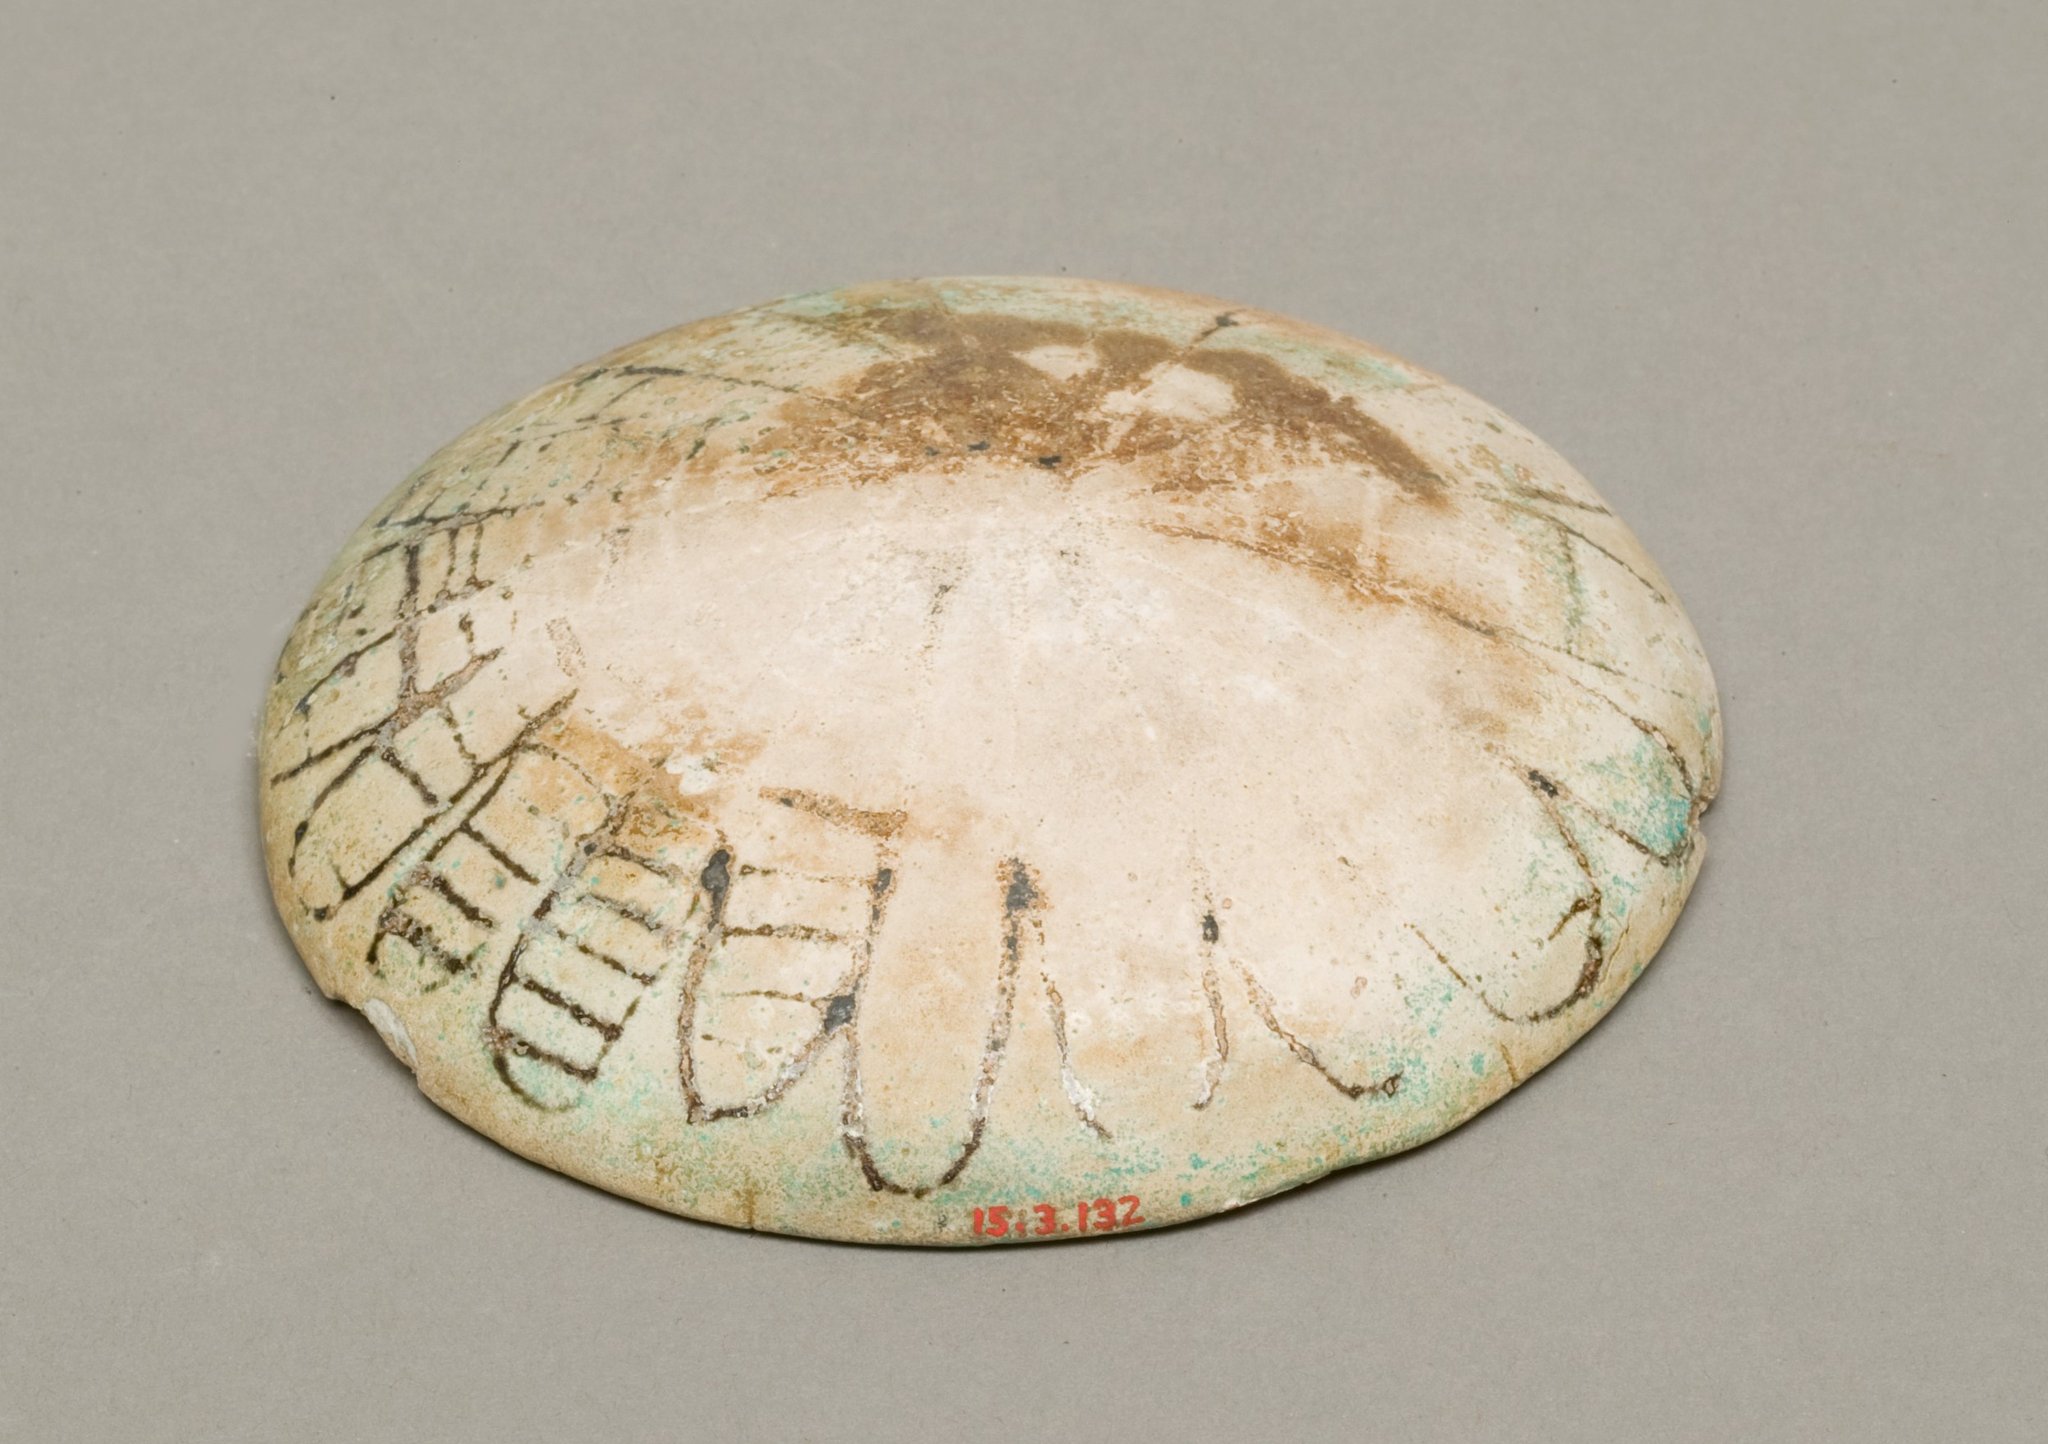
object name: jar with lid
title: Lid for a Jar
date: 1850-1700 BCE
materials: faience, paint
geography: egypt